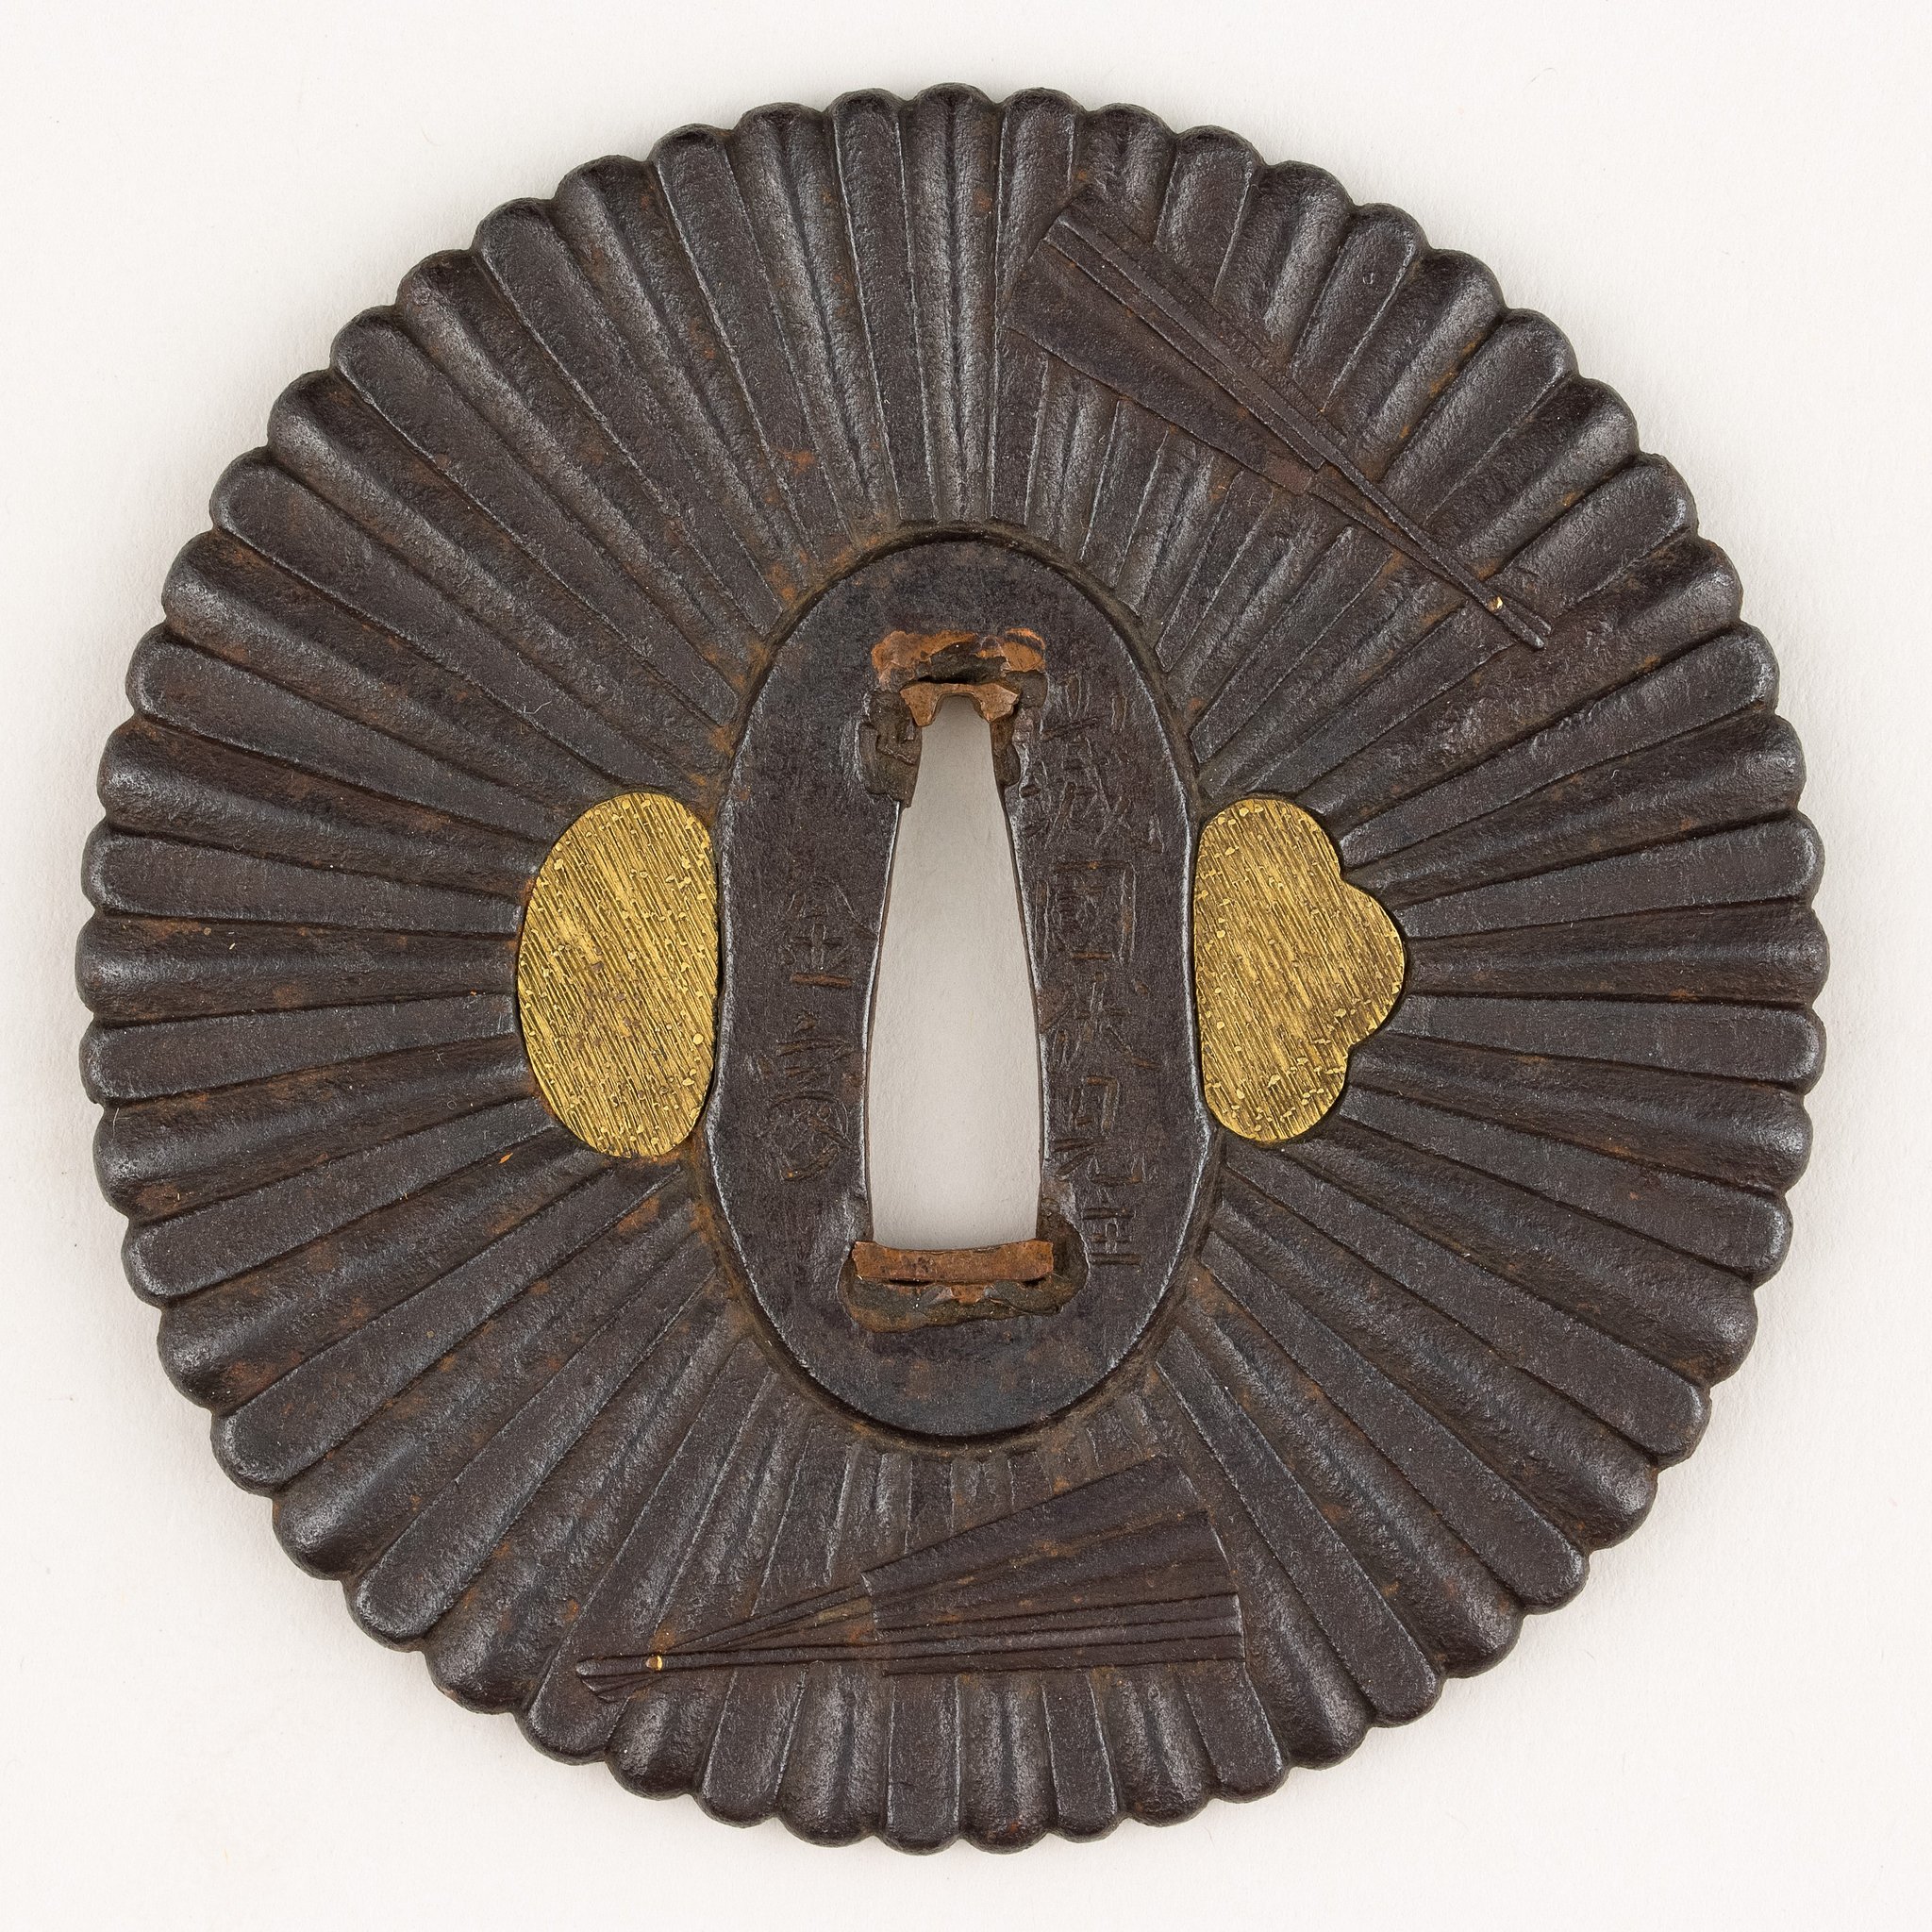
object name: sword guard tsuba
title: Sword Guard (Tsuba)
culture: japanese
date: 1601-1900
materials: gold, iron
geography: japan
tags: fans